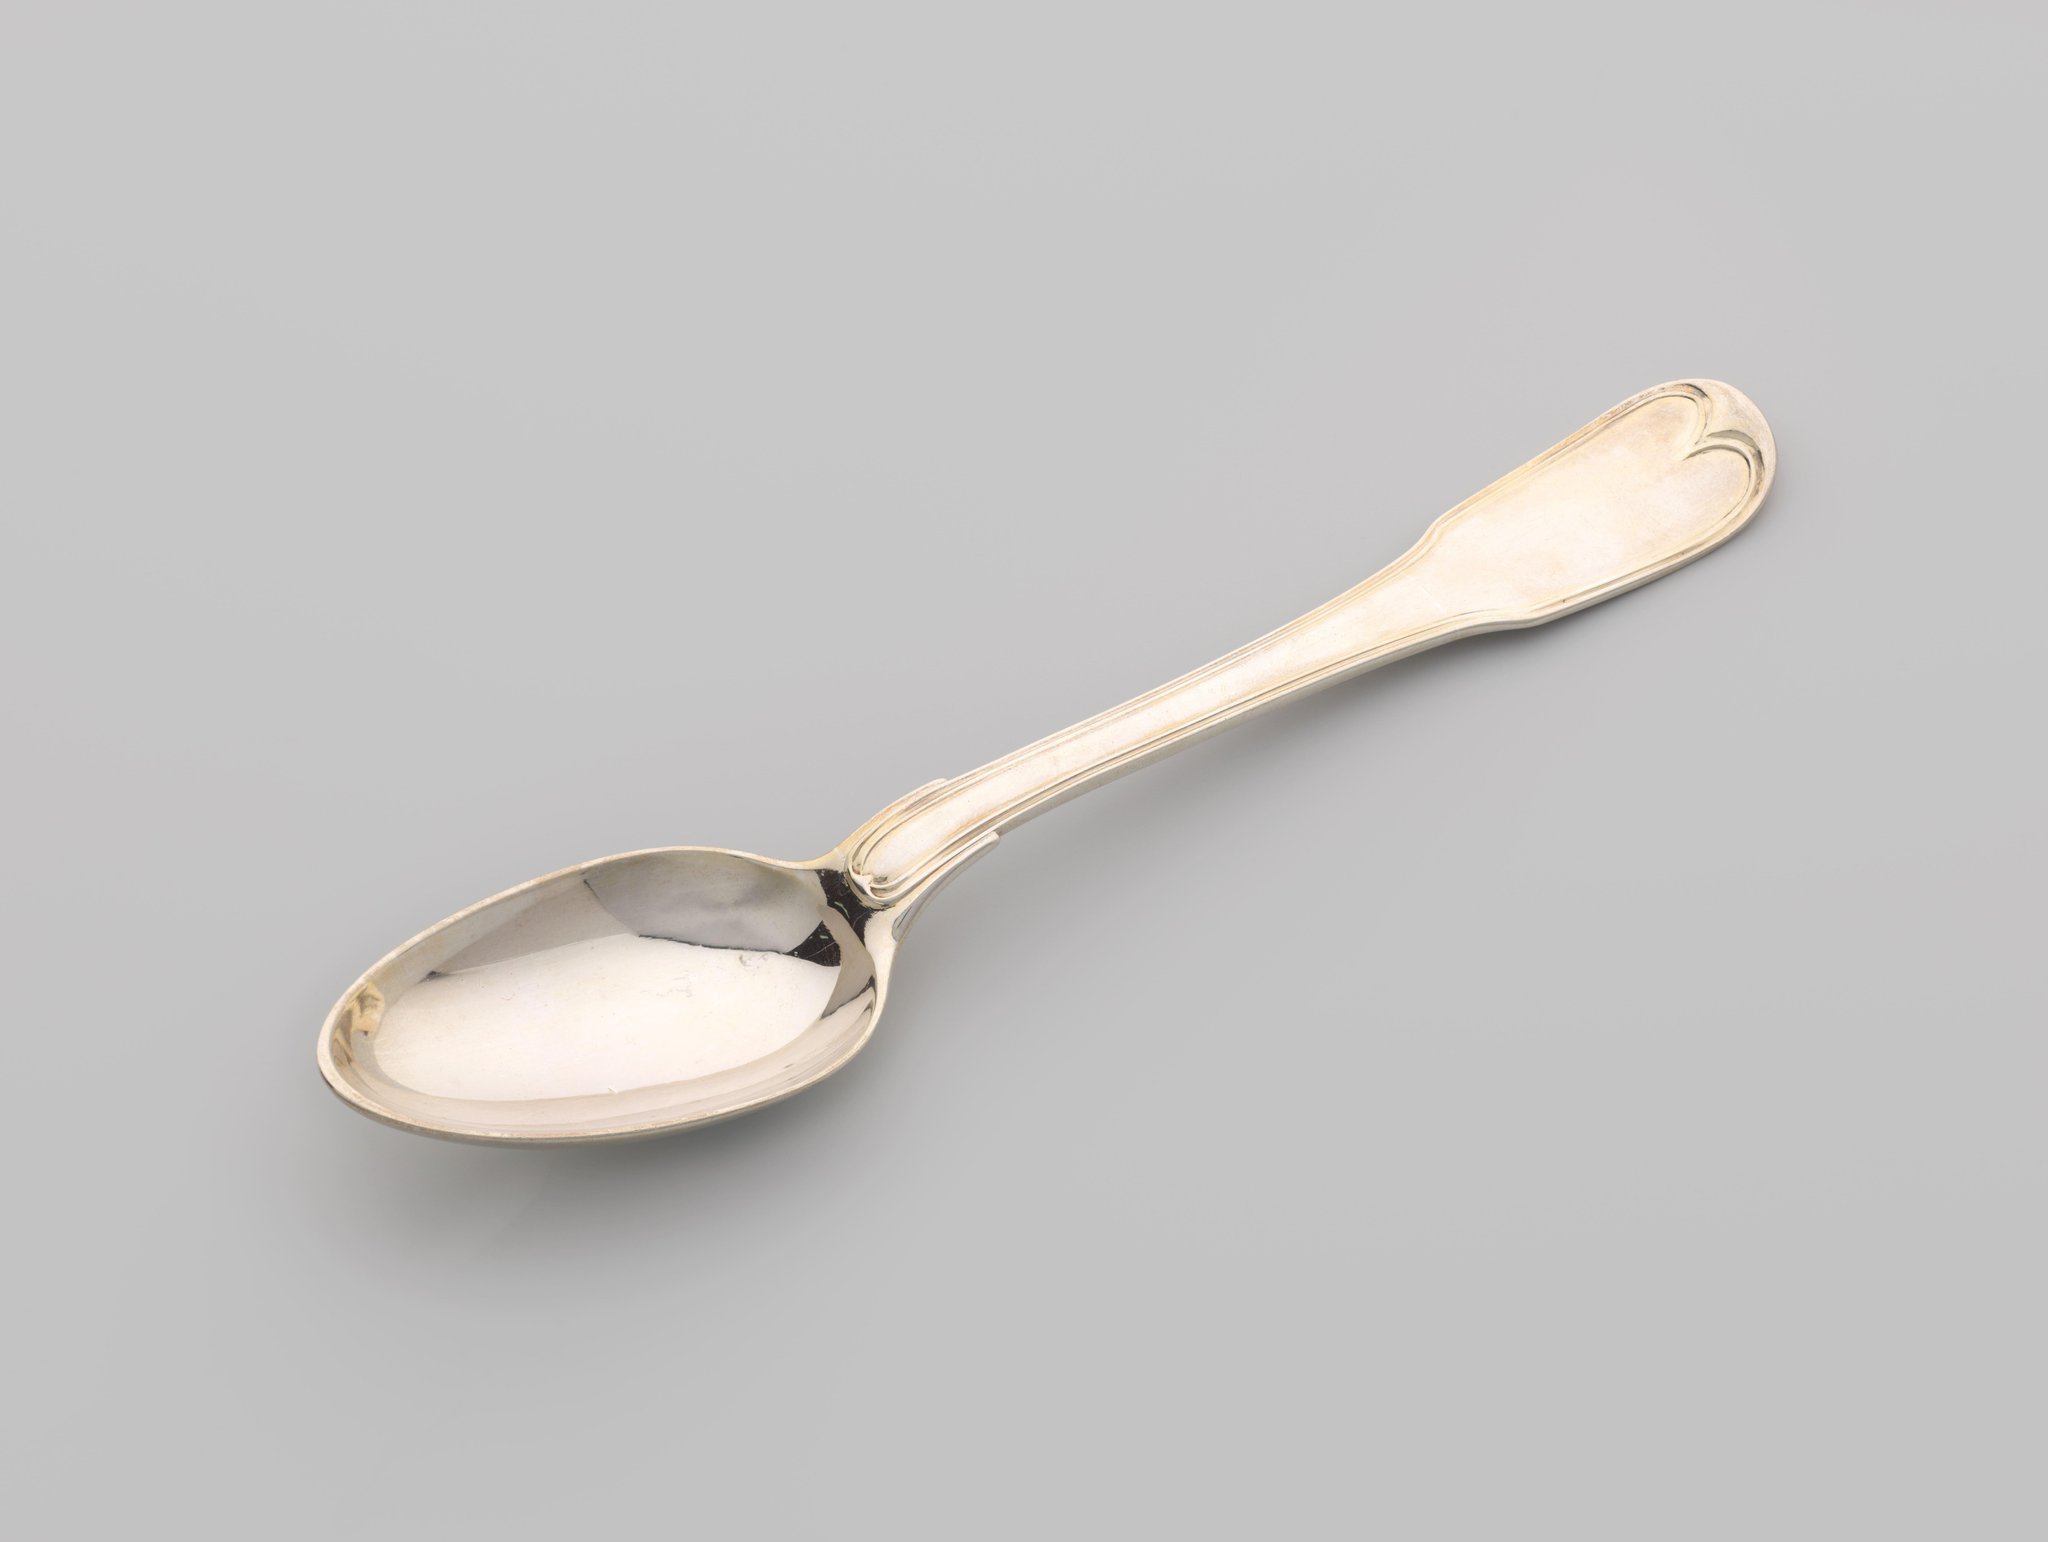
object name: spoon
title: Dessertlepel met het helmteken Clifford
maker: roelof helweg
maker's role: silversmith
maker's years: 1758-1843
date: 1806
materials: silver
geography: amsterdam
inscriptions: town mark: ‘Amsterdam’, date letter: ‘X (=1806)’, alloy mark: ‘Hollandse leeuw’, maker's mark: ‘RH in ovaal’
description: De eivormige bak van de lepel heeft een versmald uiteinde en is aan zowel boven- als onderzijde door middel van enkel lof verbonden met de platte, gebogen steel, die zich verbreedt naar het spatelvormige uiteinde. Boven- en onderzijde van de steel worden omgeven door een dubbele filetrand, die bij het uiteinde ingezwenkt is. Op de onderzijde van de spatel van zowel de lepels als de vorken is het helmteken Clifford gegraveerd.